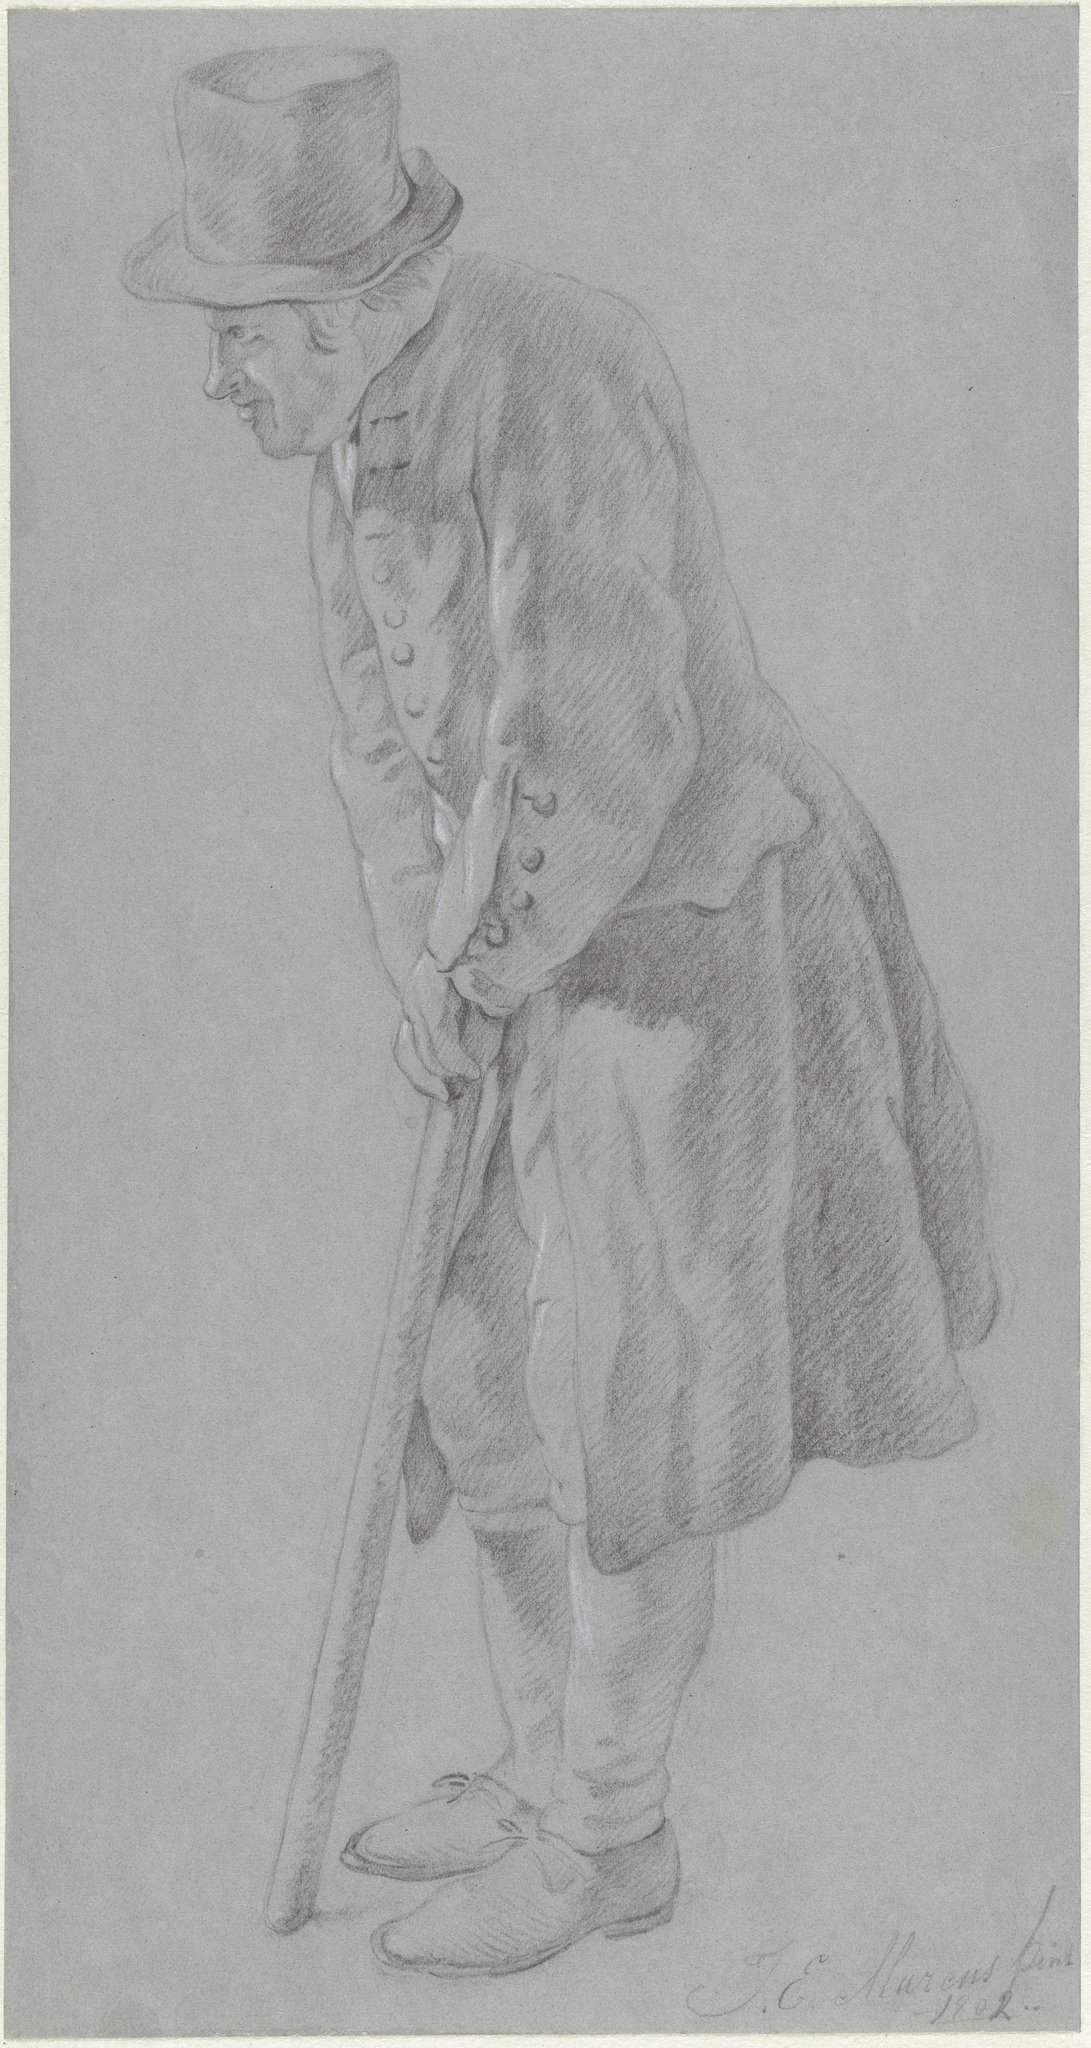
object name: drawing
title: Oude man op een stok leunend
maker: jacob ernst marcus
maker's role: draughtsman, print maker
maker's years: 1774-1826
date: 1802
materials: chalk, paper